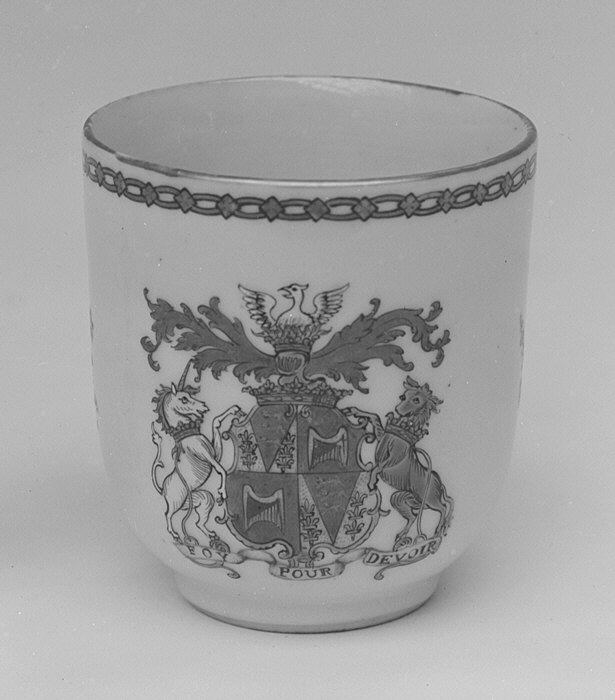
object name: cup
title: Cup (part of a service)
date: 1750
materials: hard paste porcelain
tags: birds,coat of arms